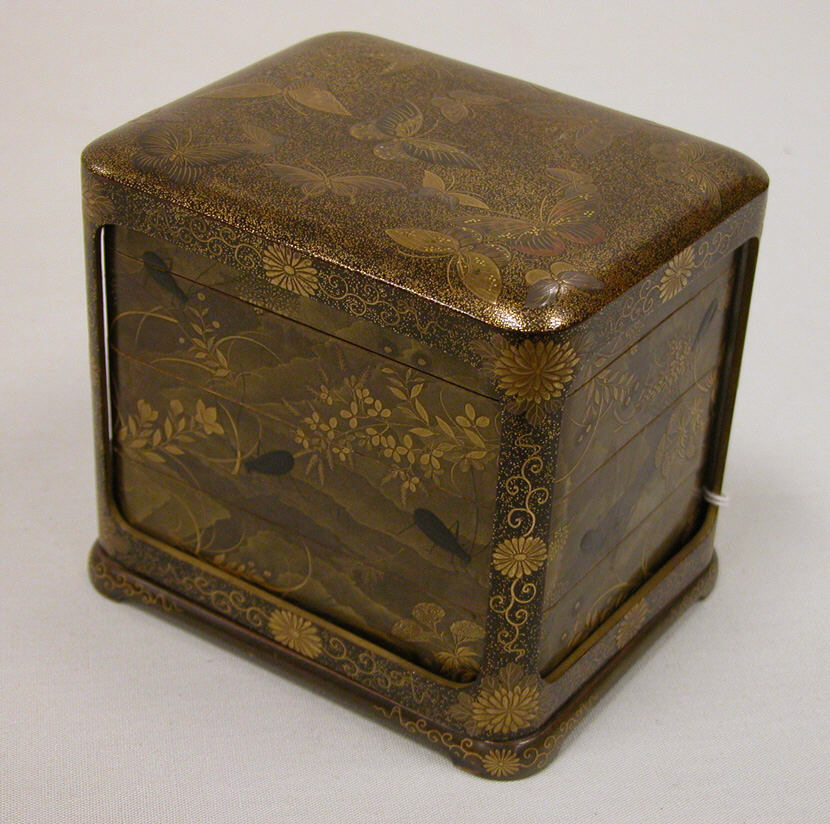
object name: tiered box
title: Tiered Box with Design of Autumn Grasses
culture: japanese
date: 1867-1900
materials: gold, lacquer, silver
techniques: maki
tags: insects,butterflies,flowers